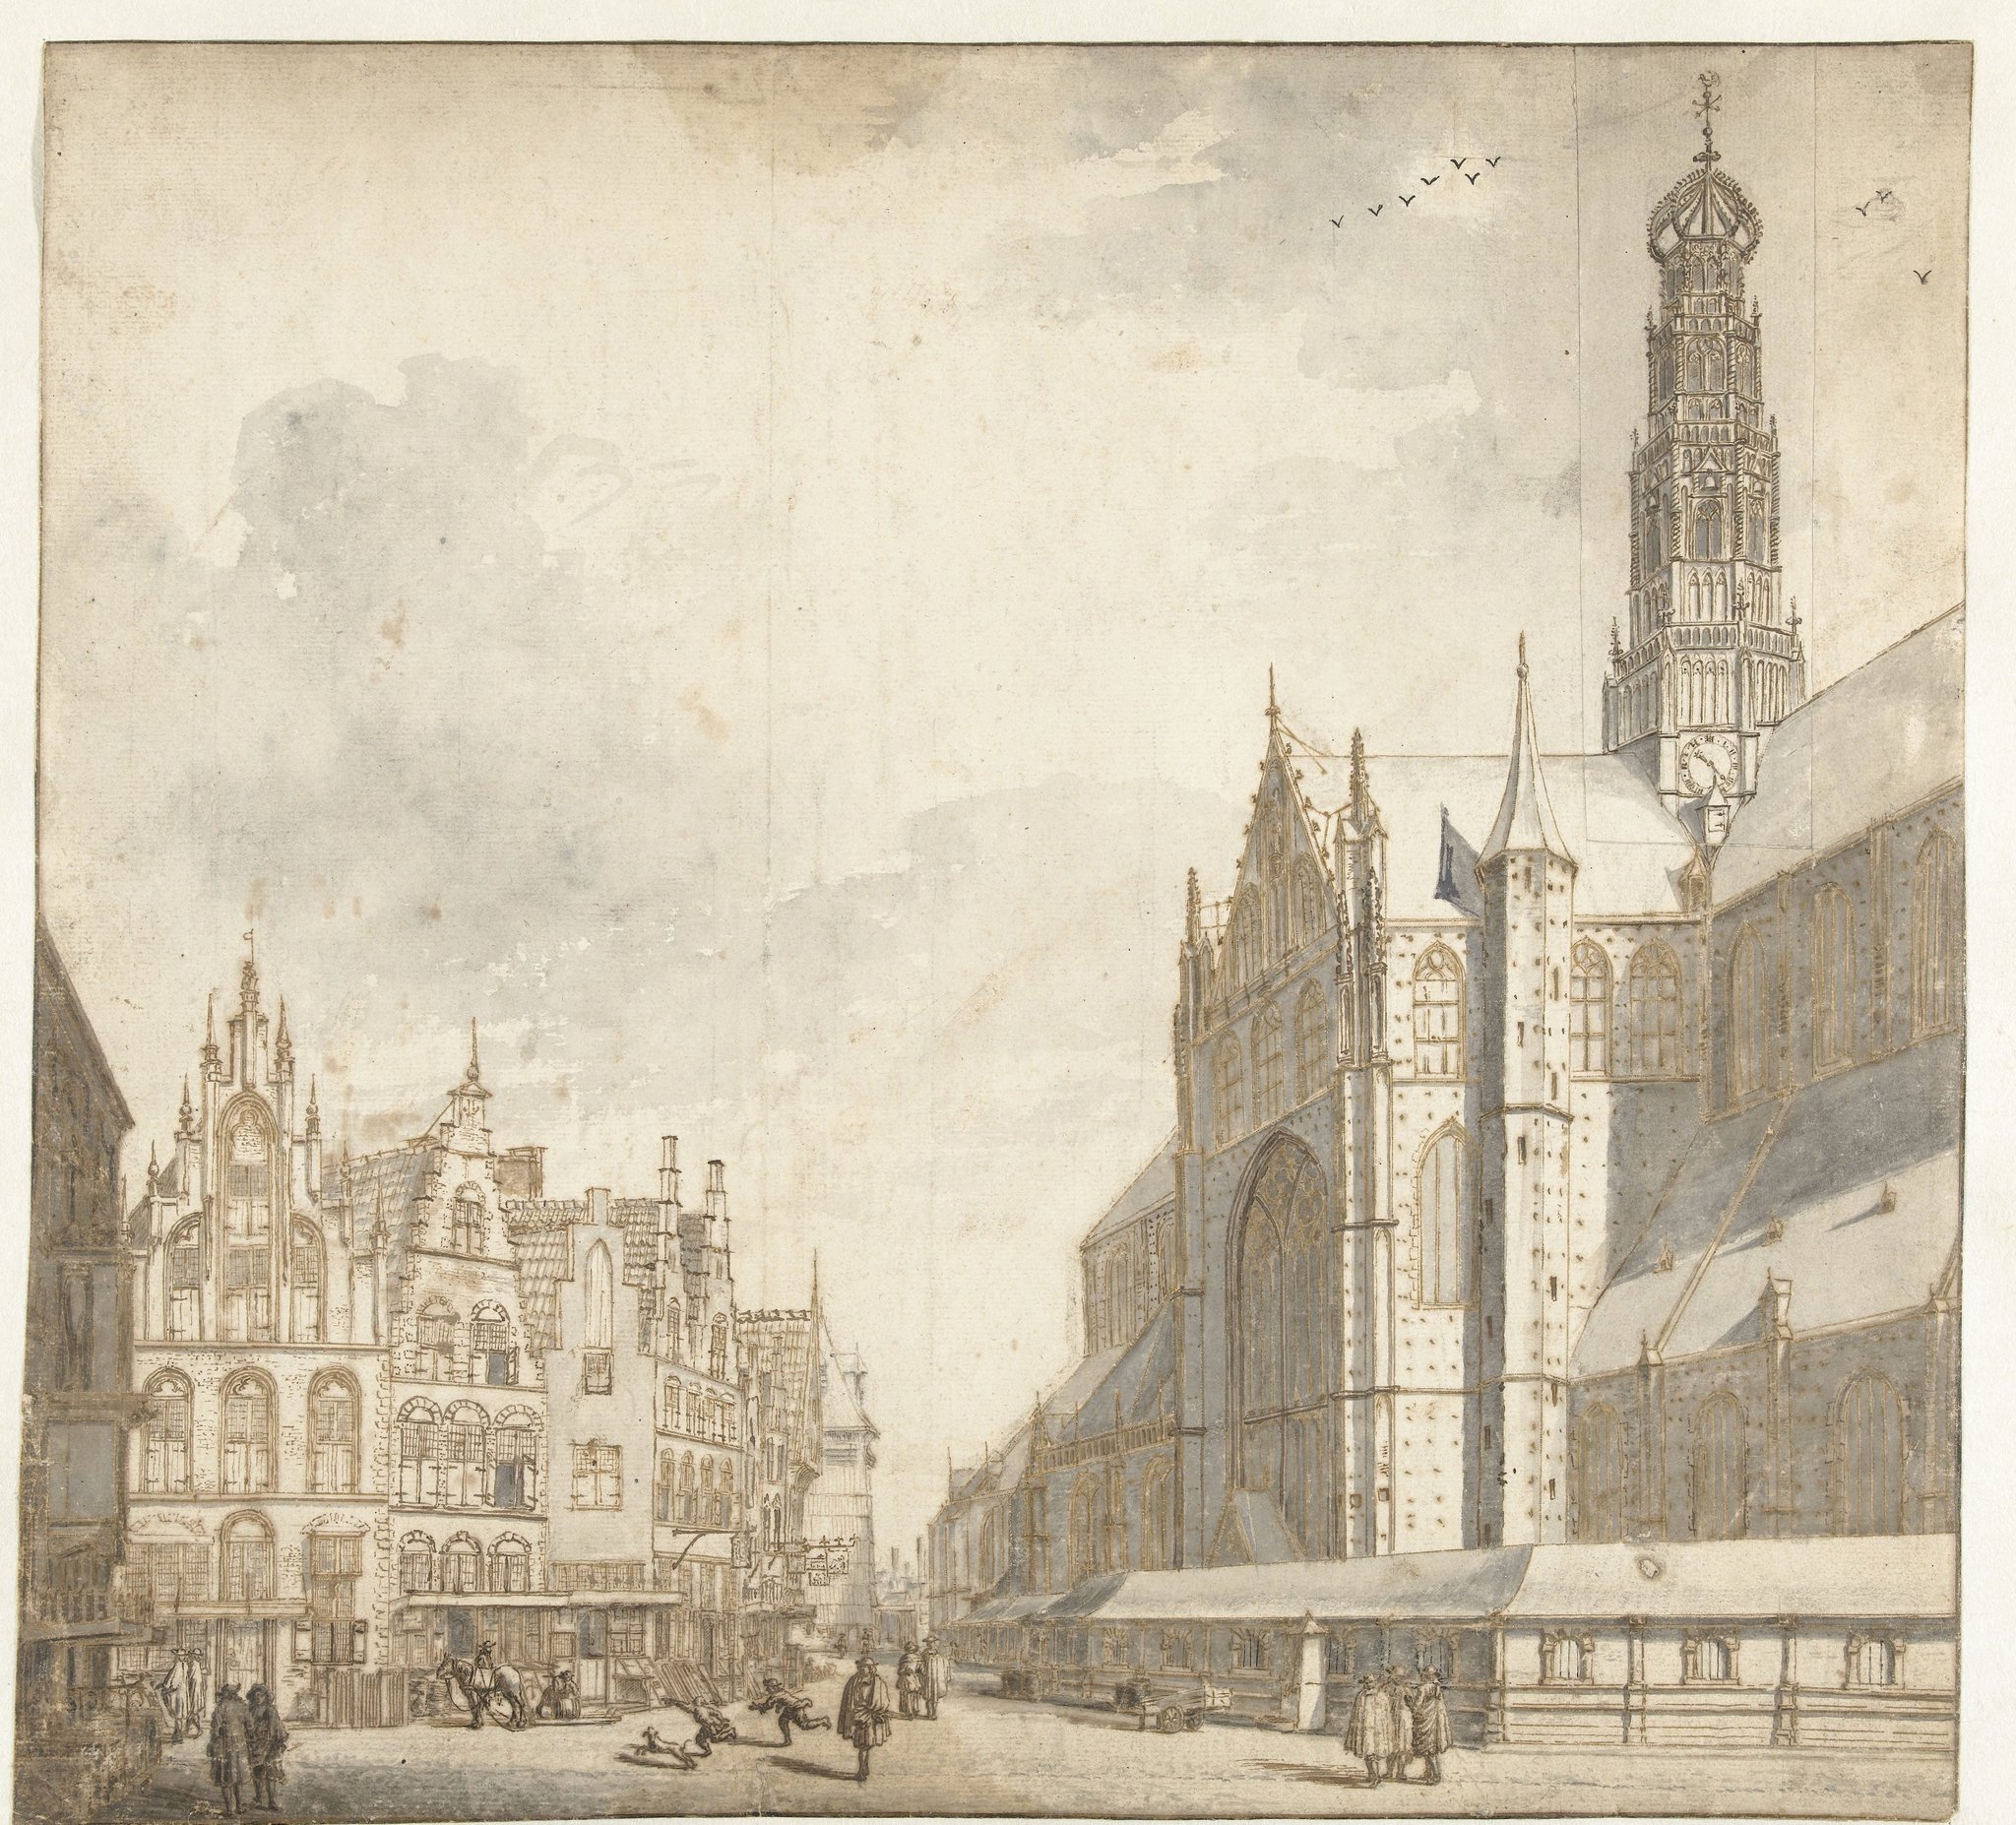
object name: drawing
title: Gezicht op de Sint-Bavo te Haarlem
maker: laurens vincentsz. van der vinne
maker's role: draughtsman, print maker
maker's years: 1658-1729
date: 1668-1729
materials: ink, paper, pencil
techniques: brush, pen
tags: church (exterior), public road, haarlem